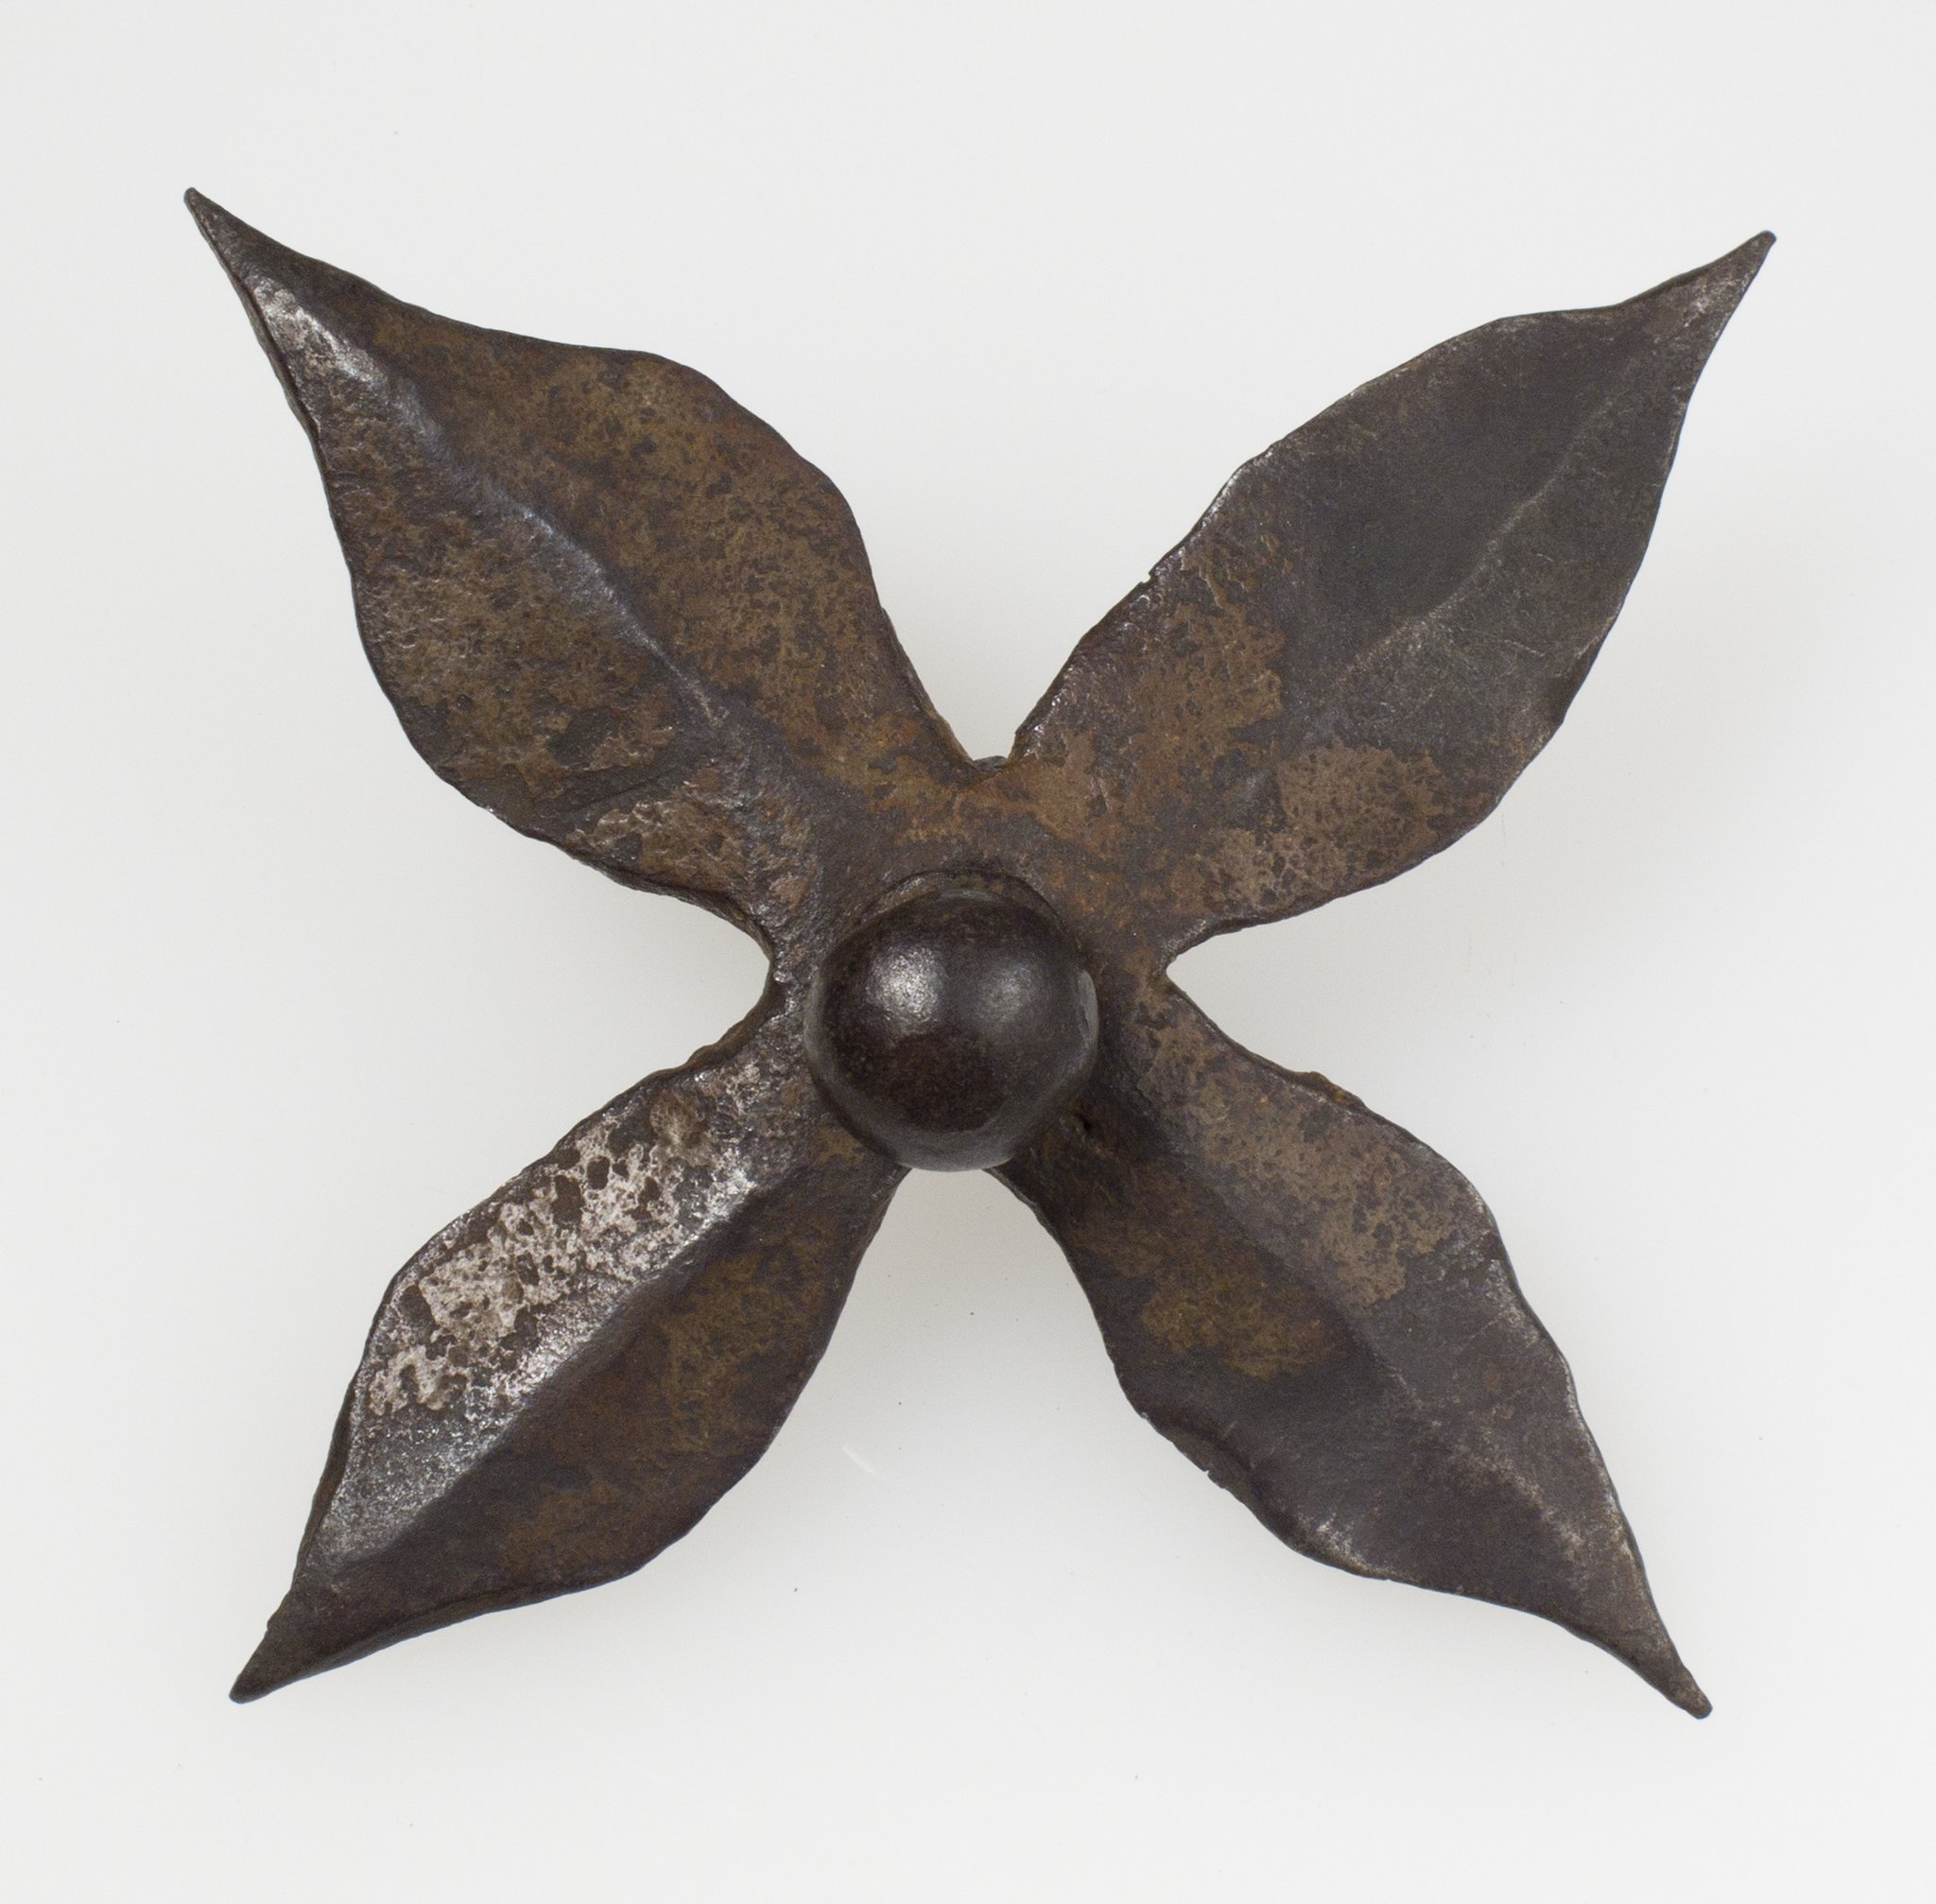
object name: plate and nail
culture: european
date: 1401-1600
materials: iron